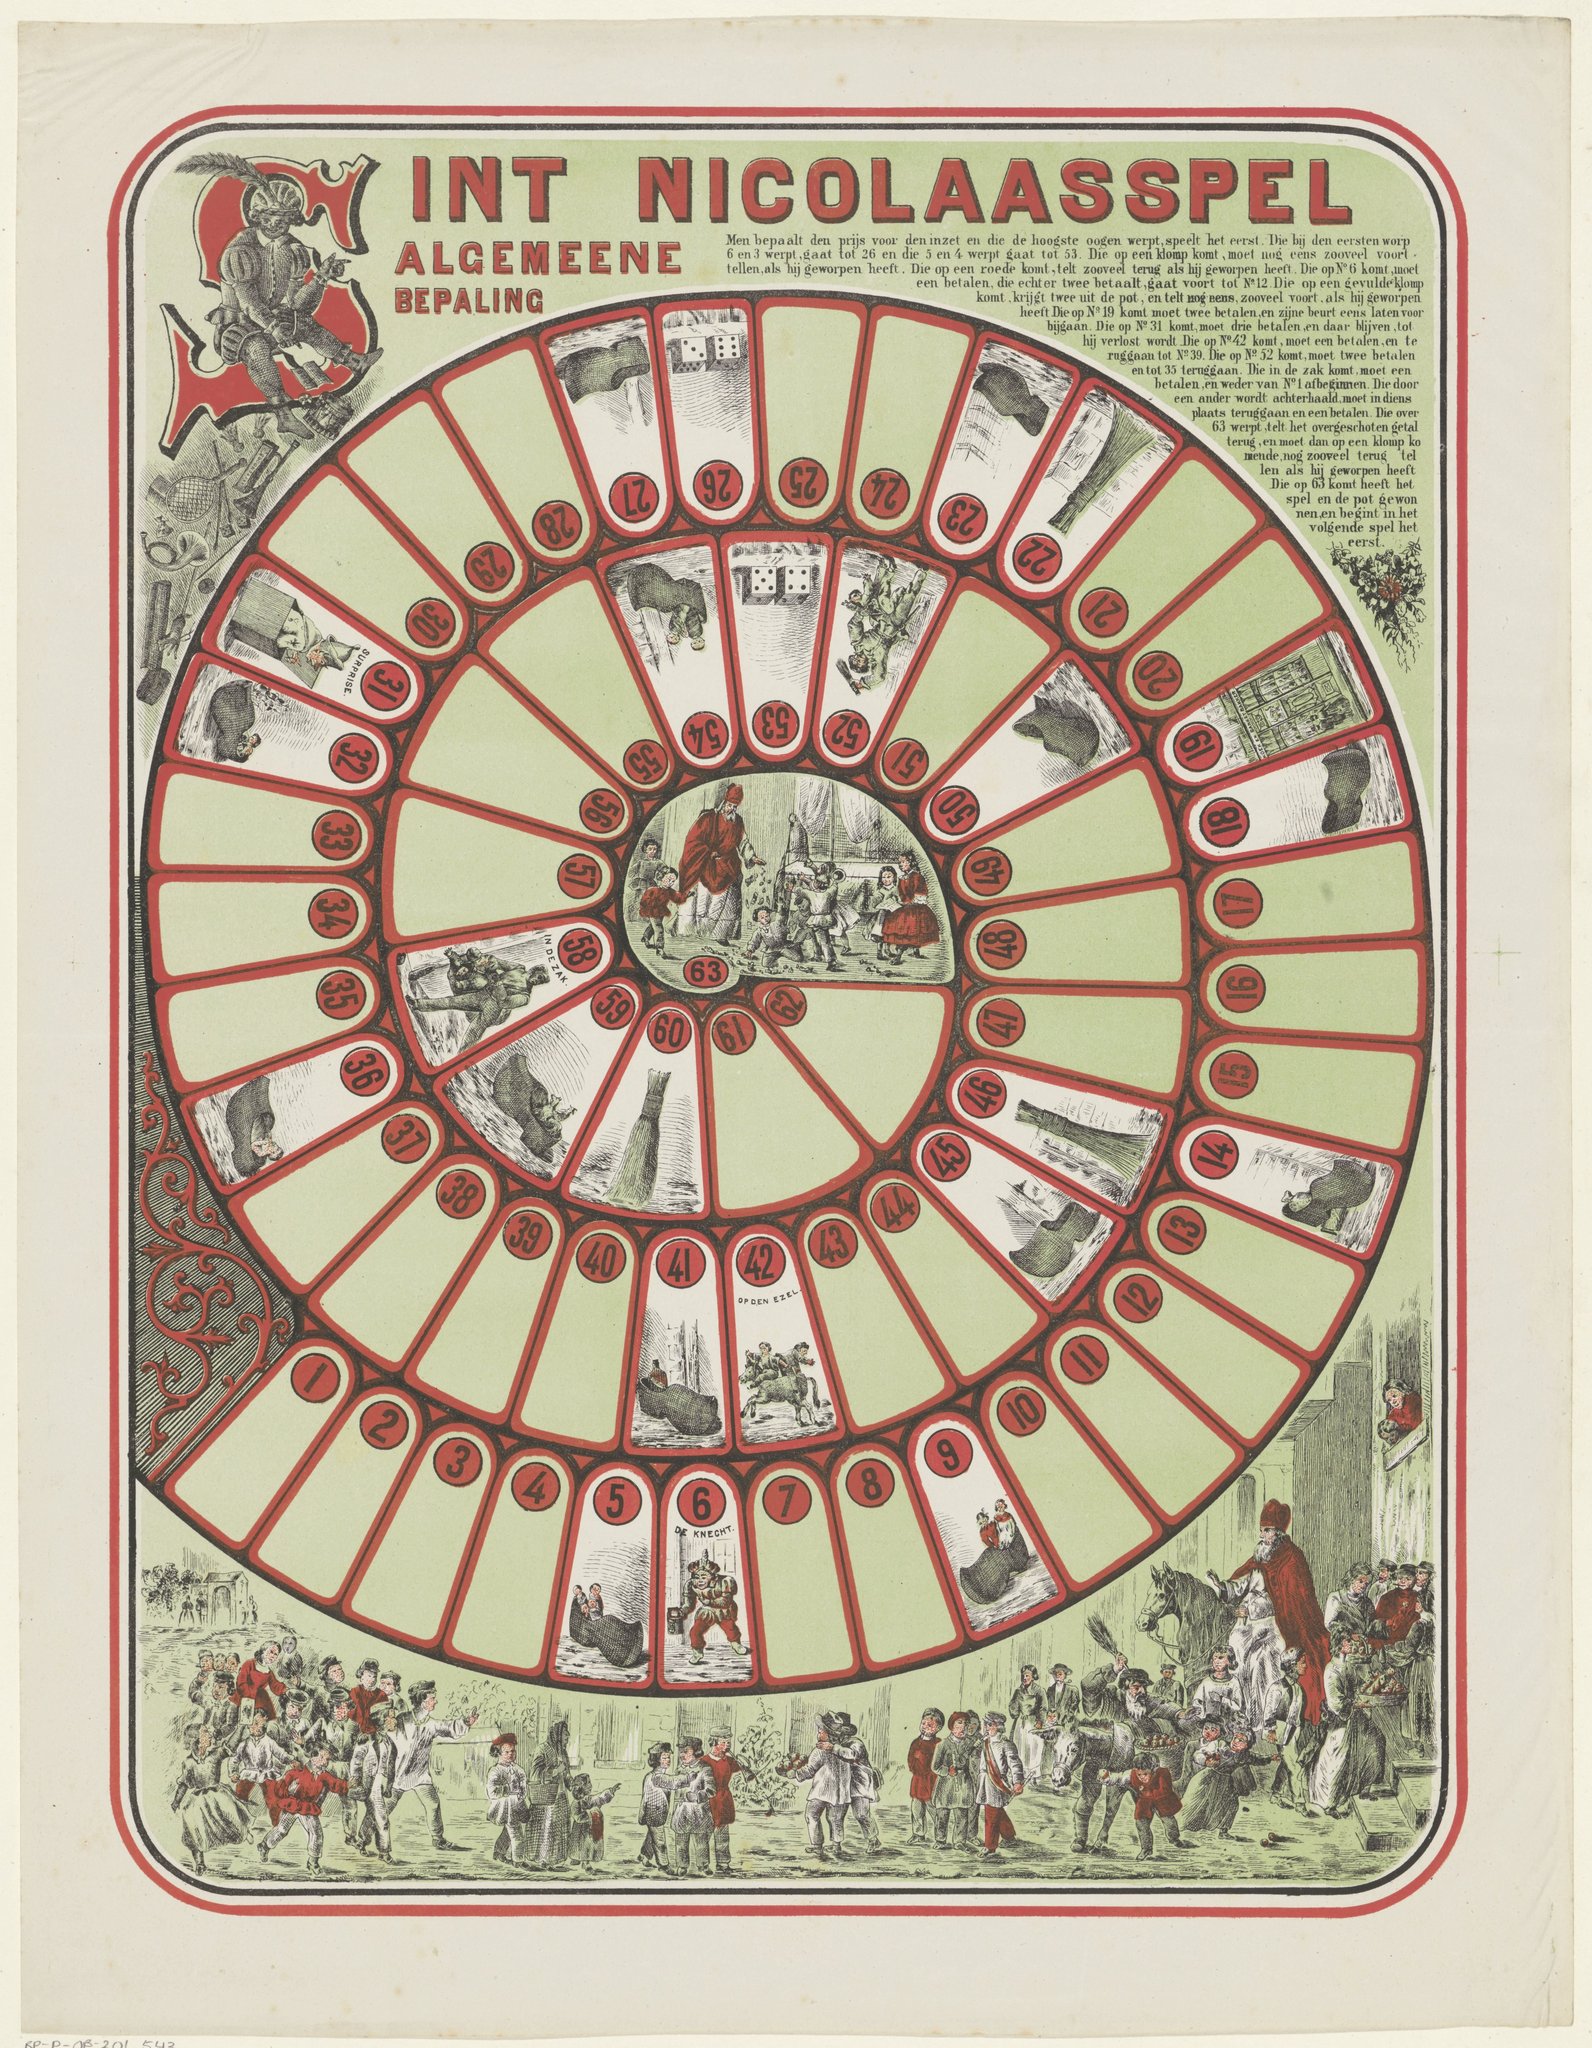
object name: gameboard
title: St Nicholas Game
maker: Anonymous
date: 1890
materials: paper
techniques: lithograph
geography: amsterdam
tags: board-games of chance, the bishop nicholas of myra (or bari); possible attributes: anchor, boat, three golden balls (on a book), three purses, three children in a tub, three maidens, festivities on st. nicholas (eve) (december 5), board-games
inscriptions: collector's mark: Lugt 2760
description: Here the servant of Saint Nicholas appears each time in a different guise. At upper left is a capital letter ‘S’ with a Pete as we know him now: black and wearing a Renaissance-style costume. ‘The servant’ in box 6 has a pale complexion; the one in box 52 seems to be of Mediterranean origin, with a beautiful moustache and goatee. In box 58 a dark, menacing tough-guy puts some miscreants in his sack.